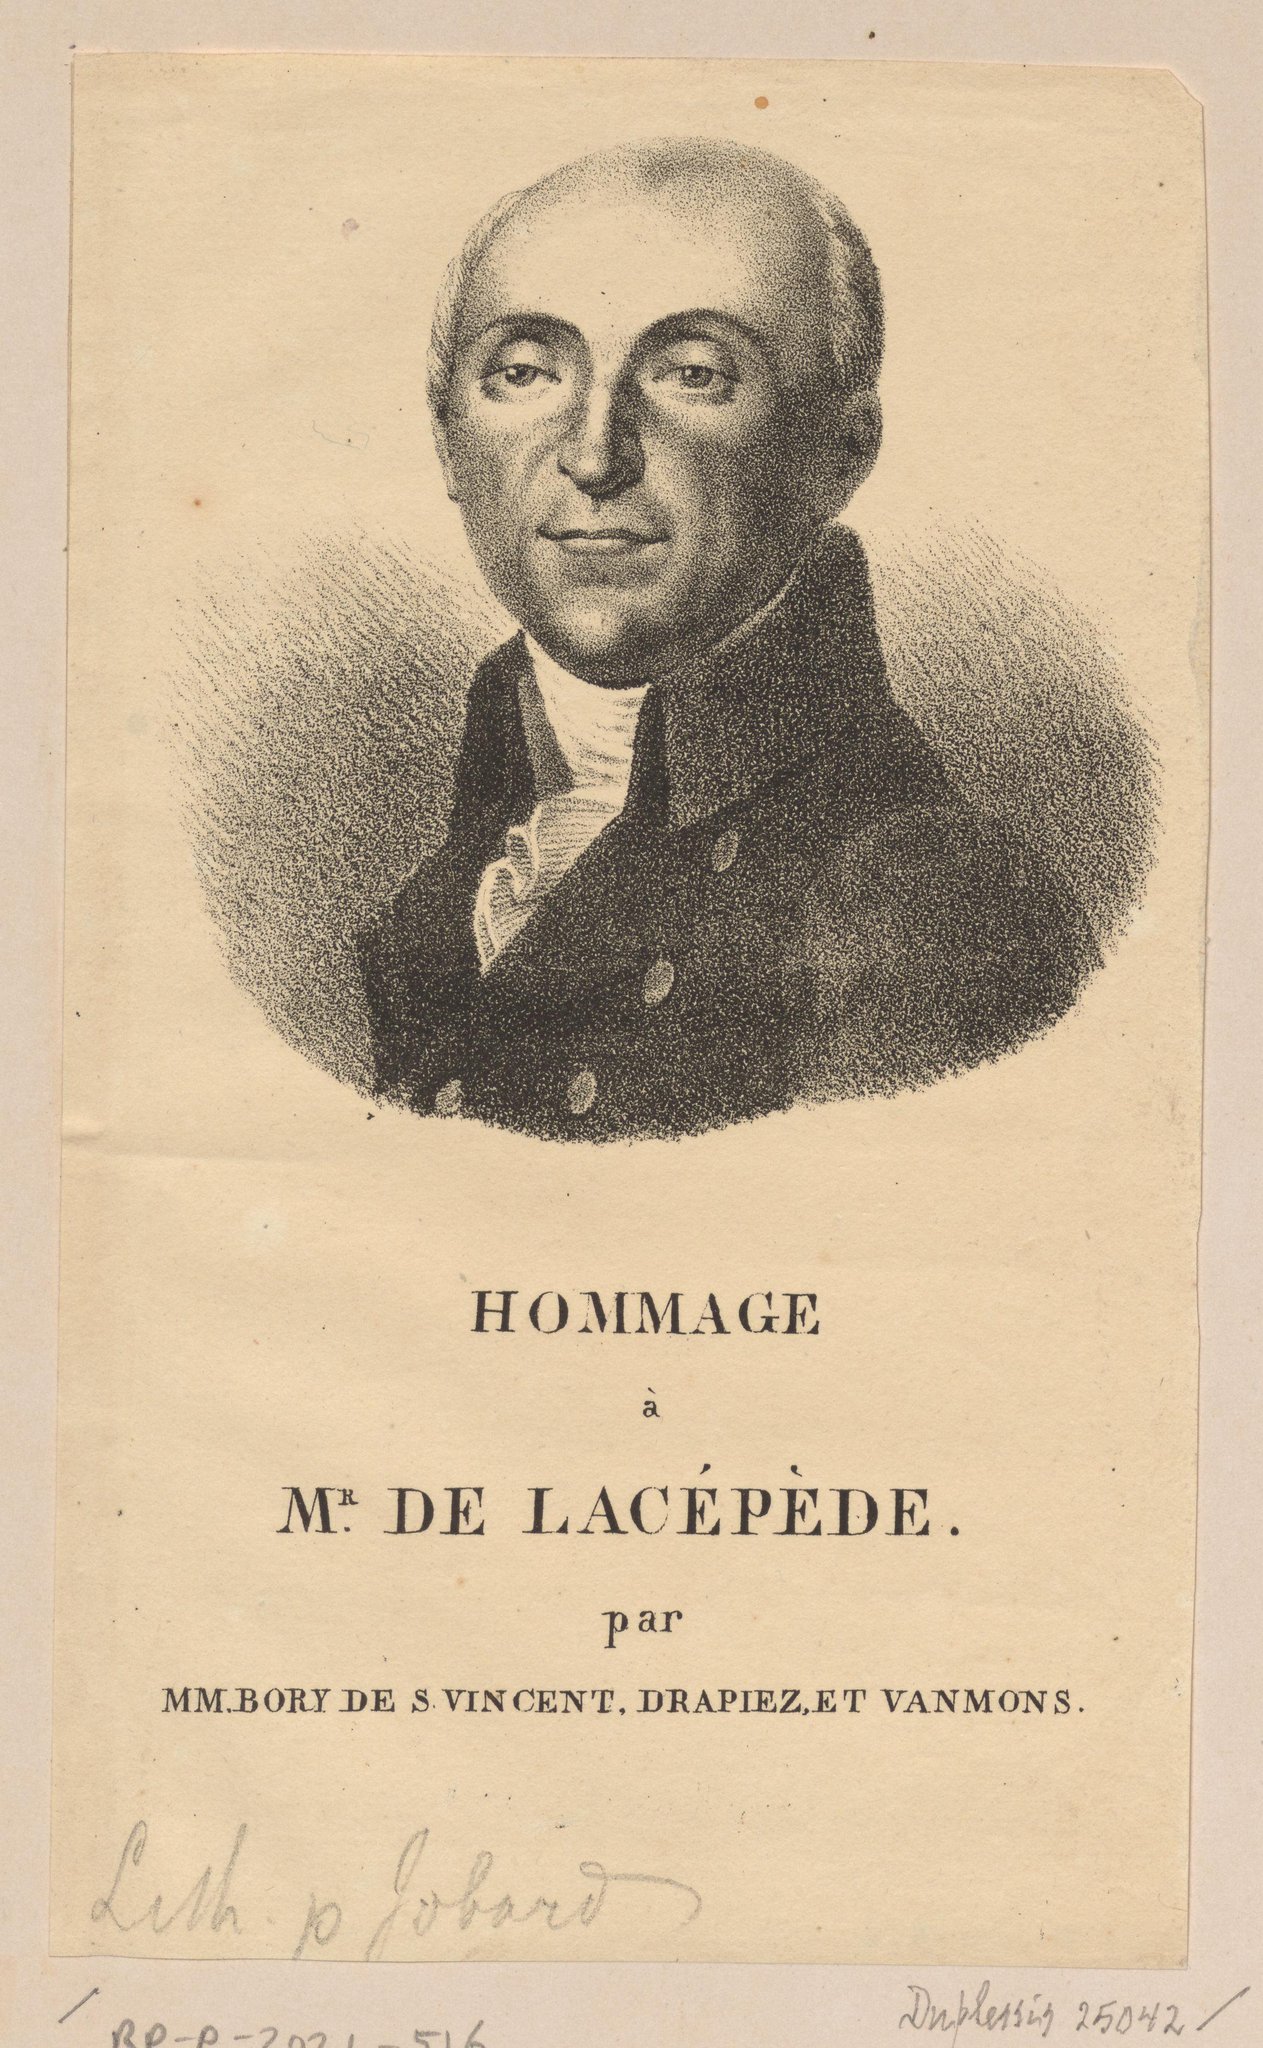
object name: book illustration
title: Portret van Bernard Germain de Lacépède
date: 1820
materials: paper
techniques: lithograph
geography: brussels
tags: politician, historical persons, politician, e.g. party leader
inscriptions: inscription: ‘Lith. p Jobard’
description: Prent waarschijnlijk uit: Annales générales des sciences physiques, vol. 6, 1820.